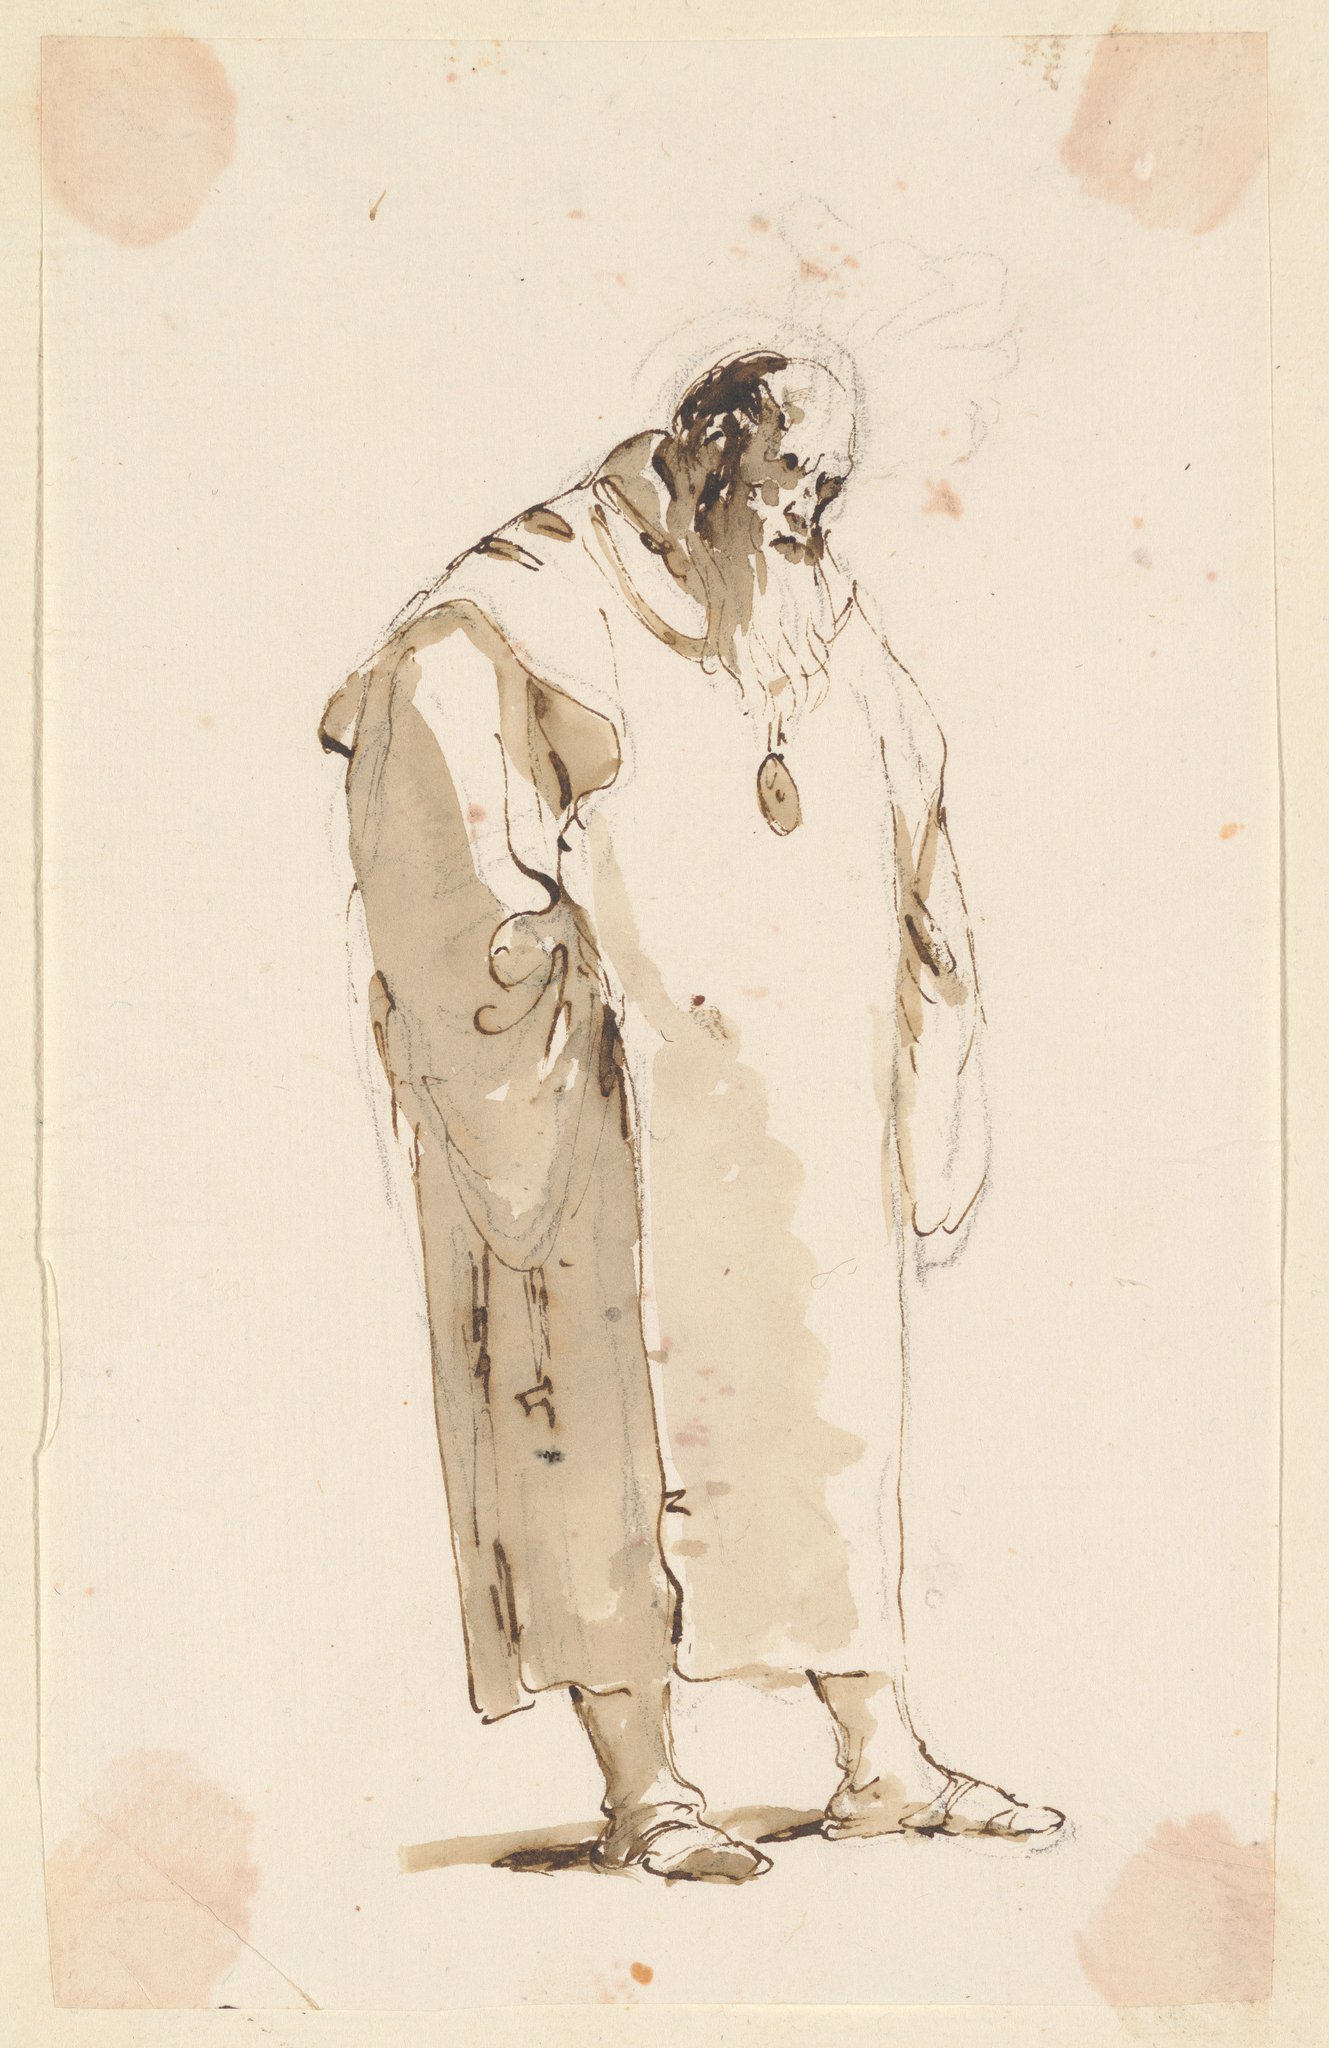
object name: drawing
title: Standing Man, Facing Half Right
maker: giovanni battista tiepolo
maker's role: artist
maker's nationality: italian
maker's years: 1696-1770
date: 1760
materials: ink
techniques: pen, wash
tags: men